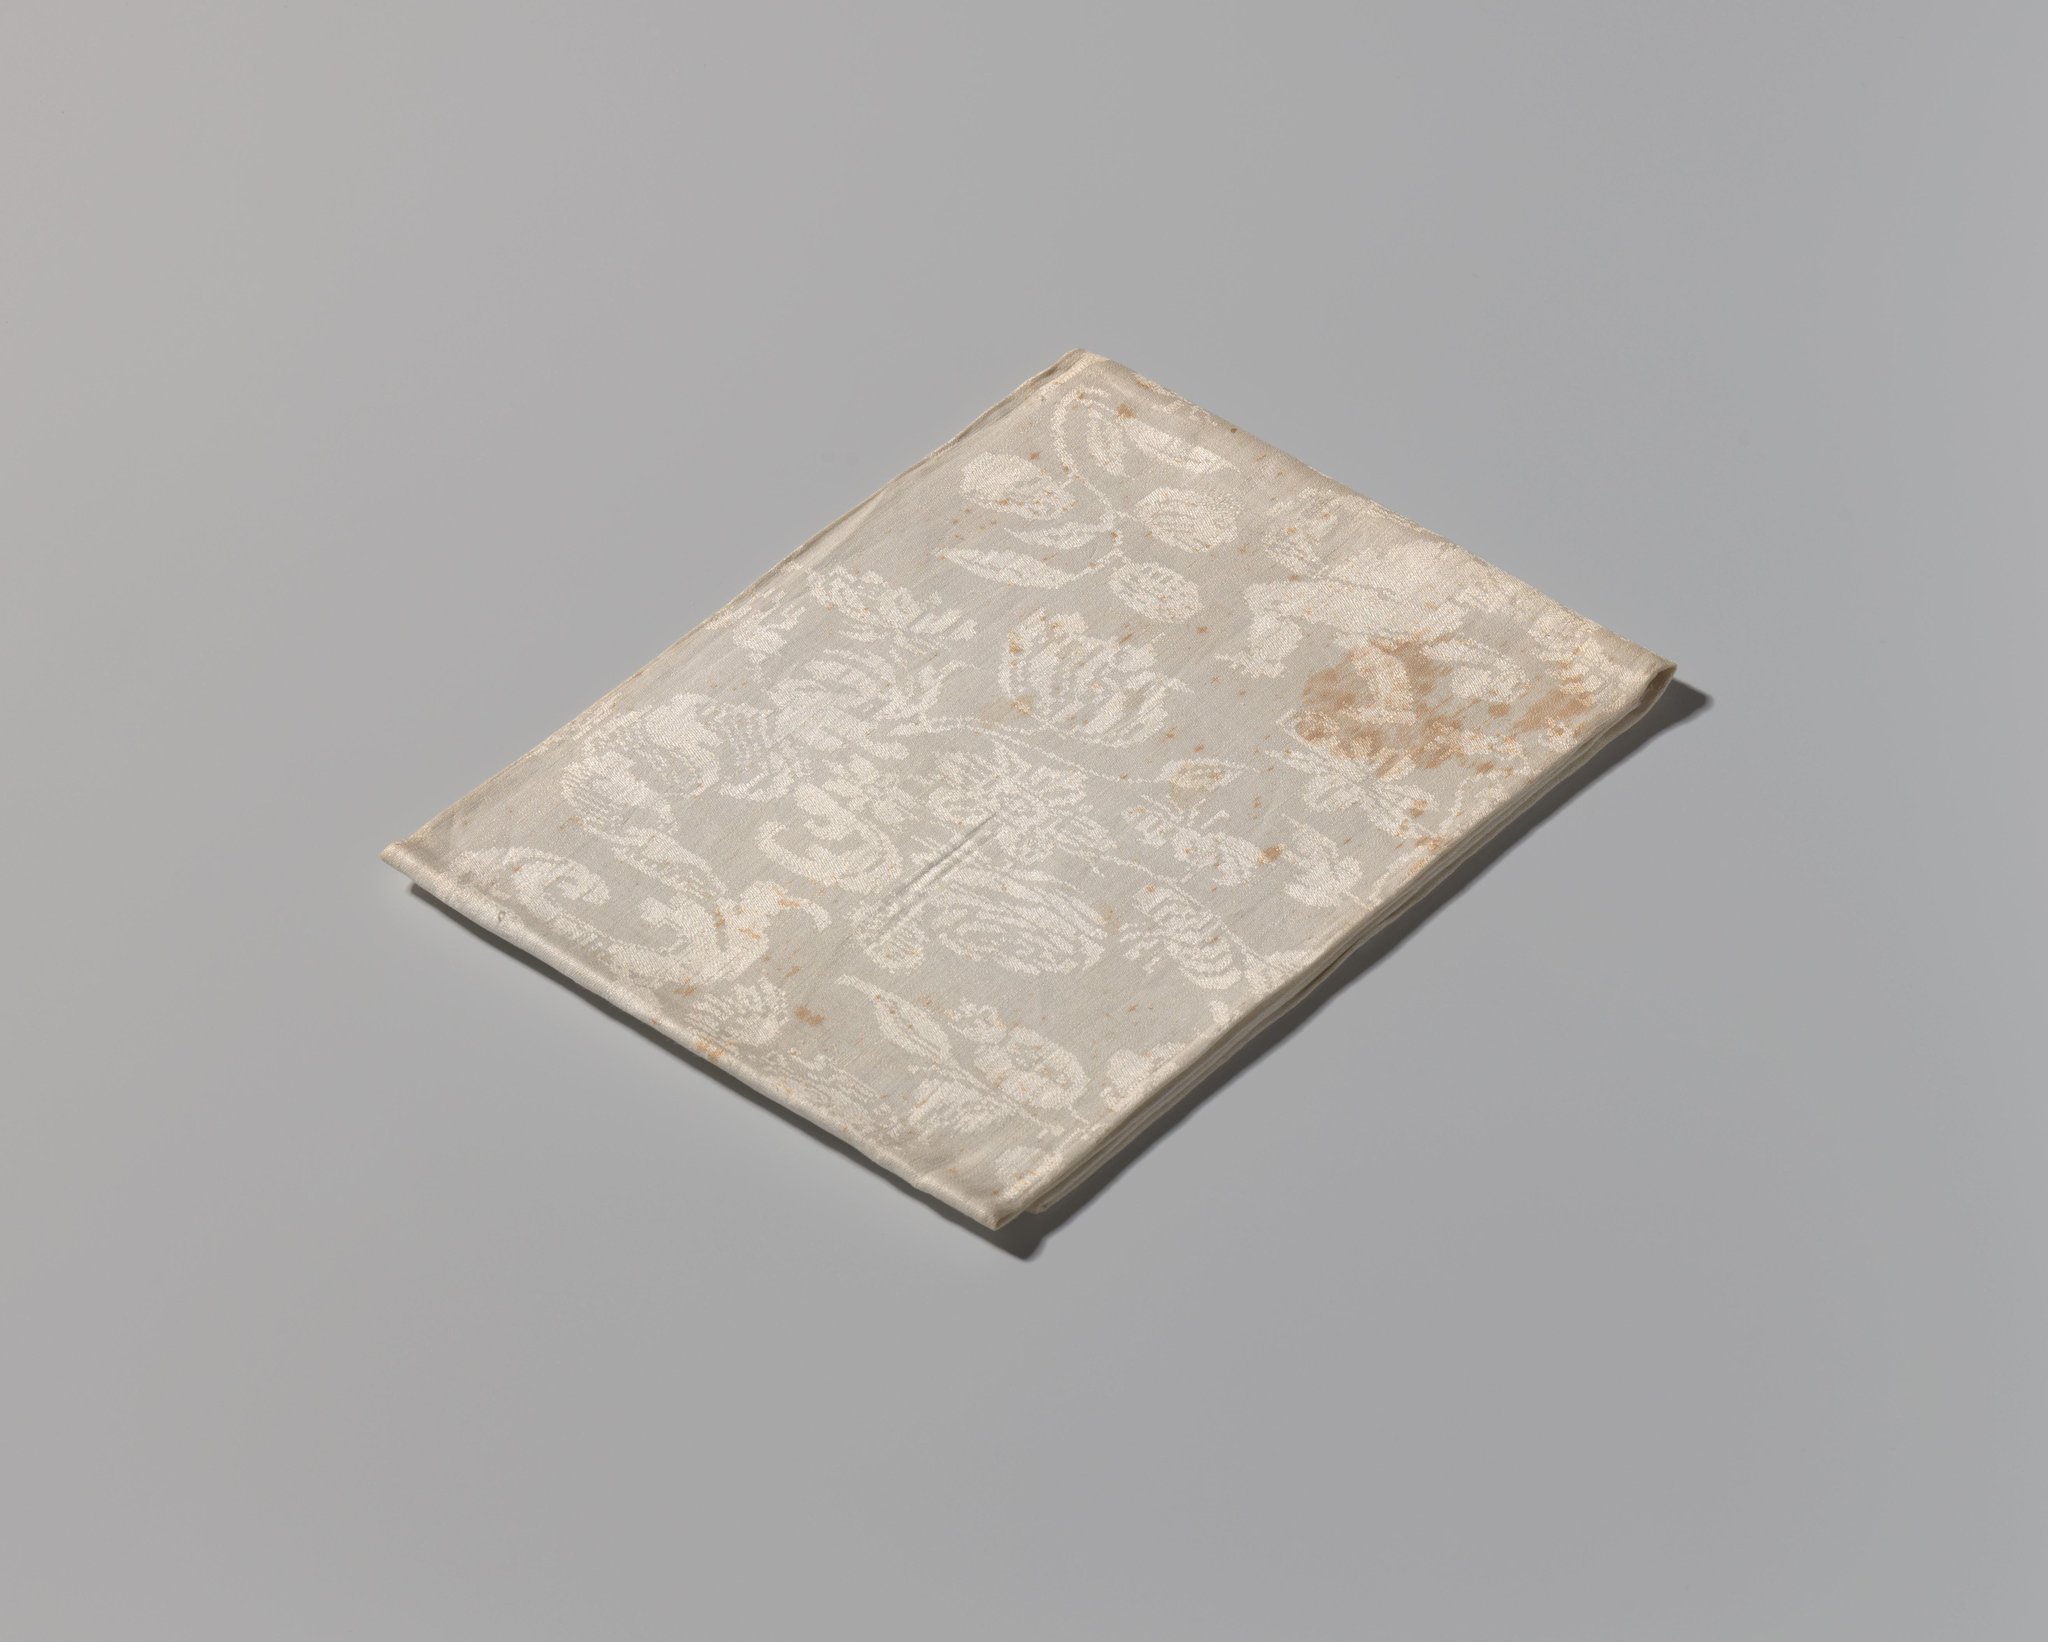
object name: napkin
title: Servet met putti, hoorns van overvloed, vruchten, bloemen en een bloemenmand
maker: Anonymous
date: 1650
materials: linen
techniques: damask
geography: northern netherlands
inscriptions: mark: ‘VWR 12’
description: Servet van linnendamast met voorstellingen van putti, hoorns van overvloed, vruchten, bloemen en een bloemenmand. Terwijl er drie assen van symmetrie zijn is het patroon in het midden volledig, maar naast de buitenste assen is een rapport gehalveerd. Er zijn drie groeperingen van telkens twee putti. 1 Een paar afgewende gevleugelde en met lendedraperie getooide putti zweven naast een libel, die op de middenlijn staat. Zij houden in de buitenste hand een voluutvormig einde van een neerhangende getorste hoorn vast, waaronder een granaat, meloen (en voor de bijpassende servetten druiven en hazelnoten), in de andere hand houden zij een staande hoorn met een roos, tijgerllelie, waarnaast een bij, en een grote tulp. 2. Een paar toegewende en achteroverbuigende putti houden op hun twee opgeheven handen een dergelijke hoorn met een grote granaatappel, een kersentak en een aalbessentak. 3 Een paar toegewende zwevende putti met aan hun voeten een insekt, dragen samen een platte mand aan de oren; in het midden rust een roos, terzijden een afhangende pioen (?), terwijl in het midden een Kaapse hyacint oprijst, waarboven twee vlinders. In de andere hand houden zij een tak met roos en papavers. Hoeken: een konijn bij voluut met eikel. Liggende randen: Dubbele adelaar in het midden op een langgerekte tak, waarin terzijde een vooroverbuigende vogel (pauw?). Staande randen: Enkelvoudige rank met bloemen en vogels, onder andere een haan.